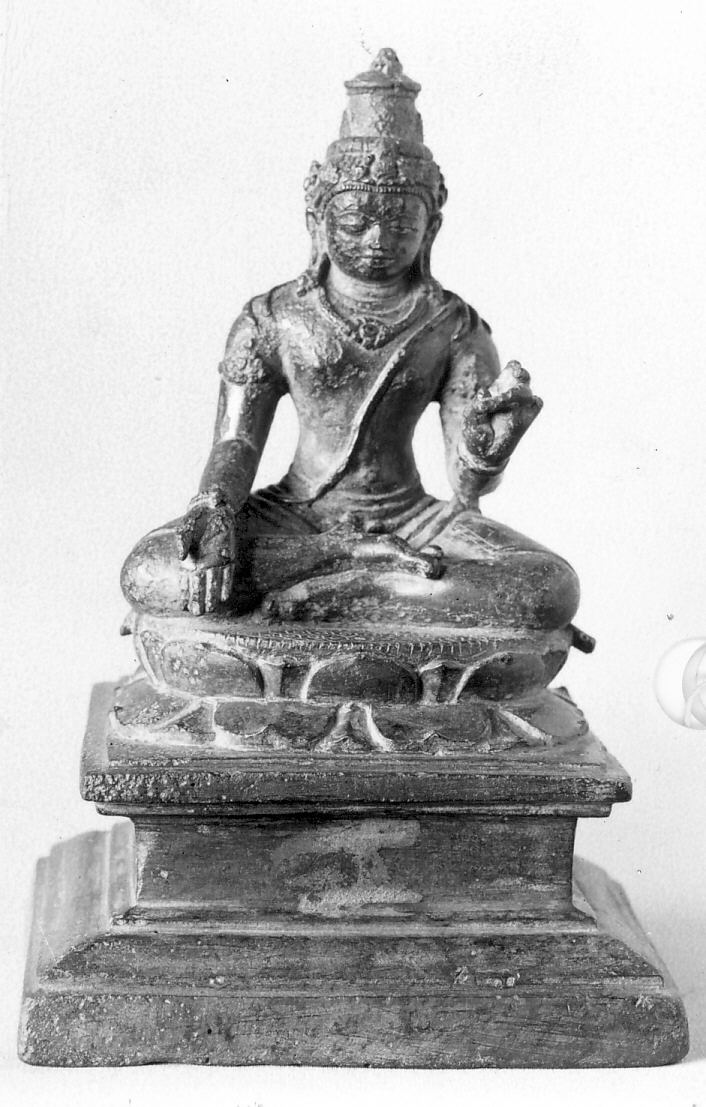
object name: statuette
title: Bodhisattva (Maitreya?)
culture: indonesian, javanese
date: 801-900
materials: bronze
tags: buddhism,bodhisattvas,maitreya